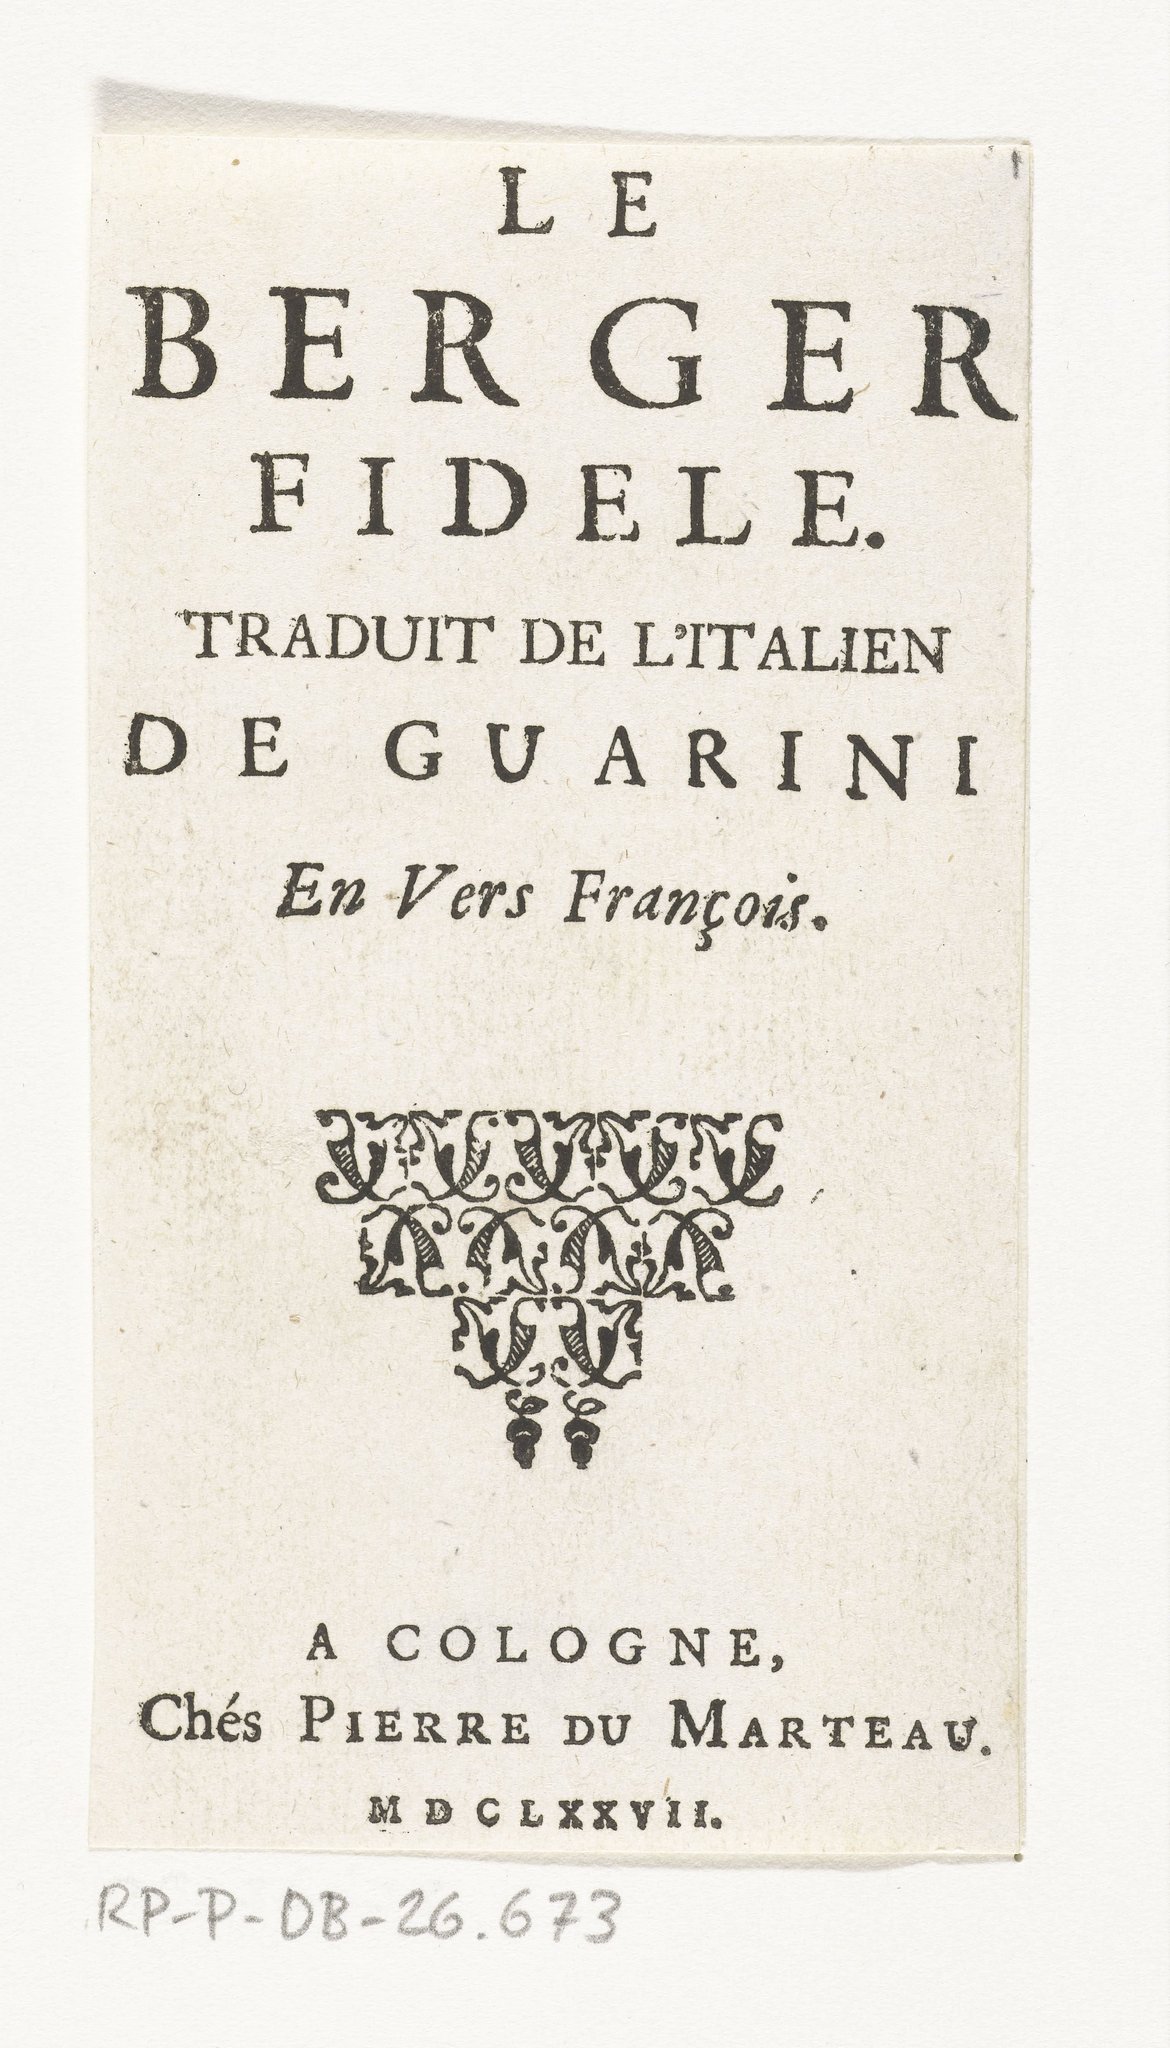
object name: print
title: Titelpagina voor G.B. Guarini, Le Berger Fidele, Cologne, Pierre du Marteau, 1677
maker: pierre marteau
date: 1677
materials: paper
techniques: letterpress printing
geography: cologne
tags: title-page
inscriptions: collector's mark: Lugt 2228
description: Titelpagina voor: G.B. Guarini, Le berger fidele, Keulen, Pierre Marteau, 1677 (fictief impressum, eigenlijk gedrukt in Leiden bij de gebroeders Hackius)